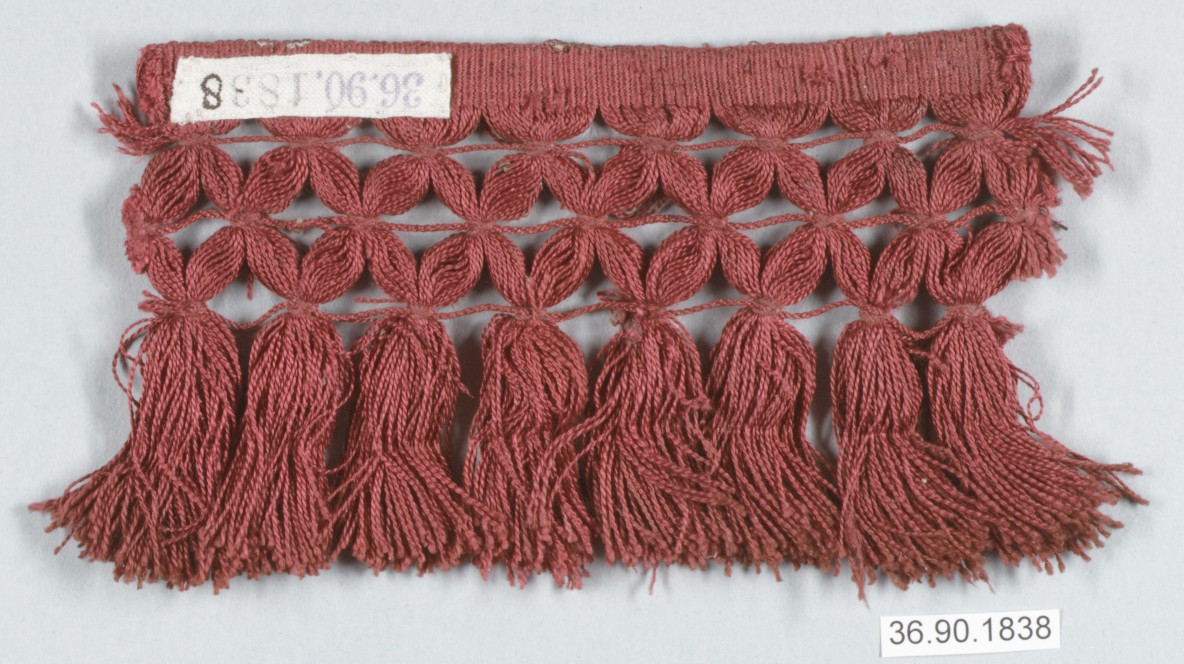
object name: fringe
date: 1801-1833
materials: silk